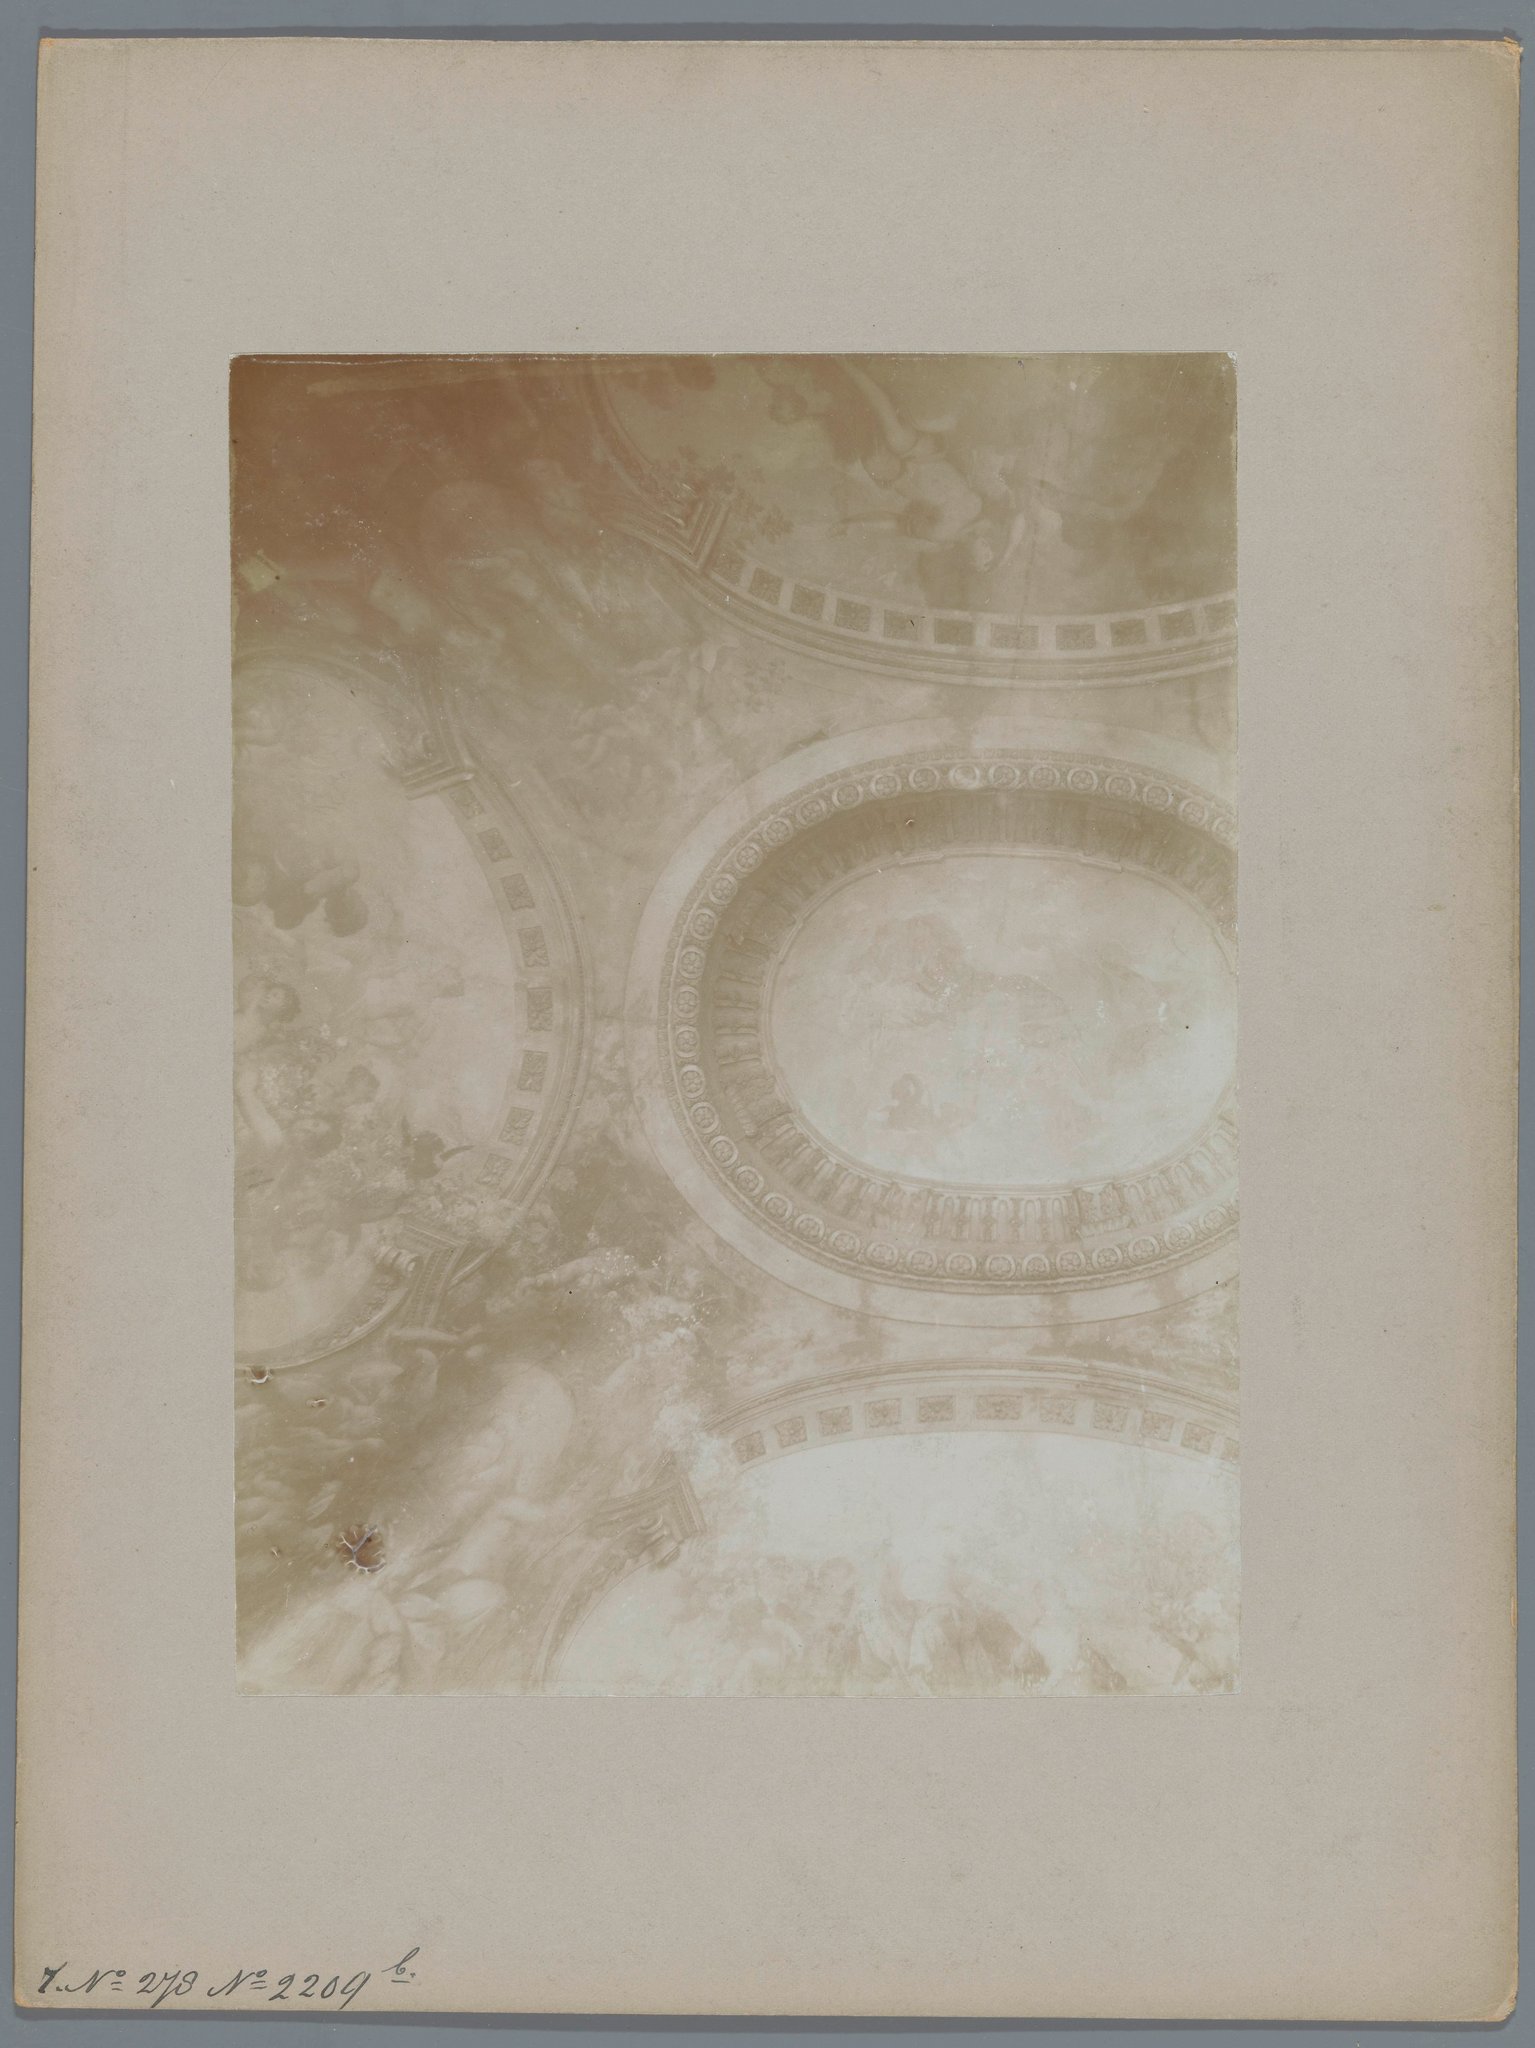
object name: photograph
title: Deel van een beschilderd koepelplafond in een huis aan het Noordeinde te Den Haag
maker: Anonymous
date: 1901-1912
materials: cardboard, photographic support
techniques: collodion silver print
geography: noordeinde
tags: (decorated) ceiling, interior ~ representation of a building, cupids: 'amores', 'amoretti', 'putti'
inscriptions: inscription: ‘Gedeelte van het middenvak plafond van den koepel van het voorm. huis Fagel Noordeinde den Haag Jan. 1912.’, inscription: ‘neg. no 15063 foto no 7289’, annotation